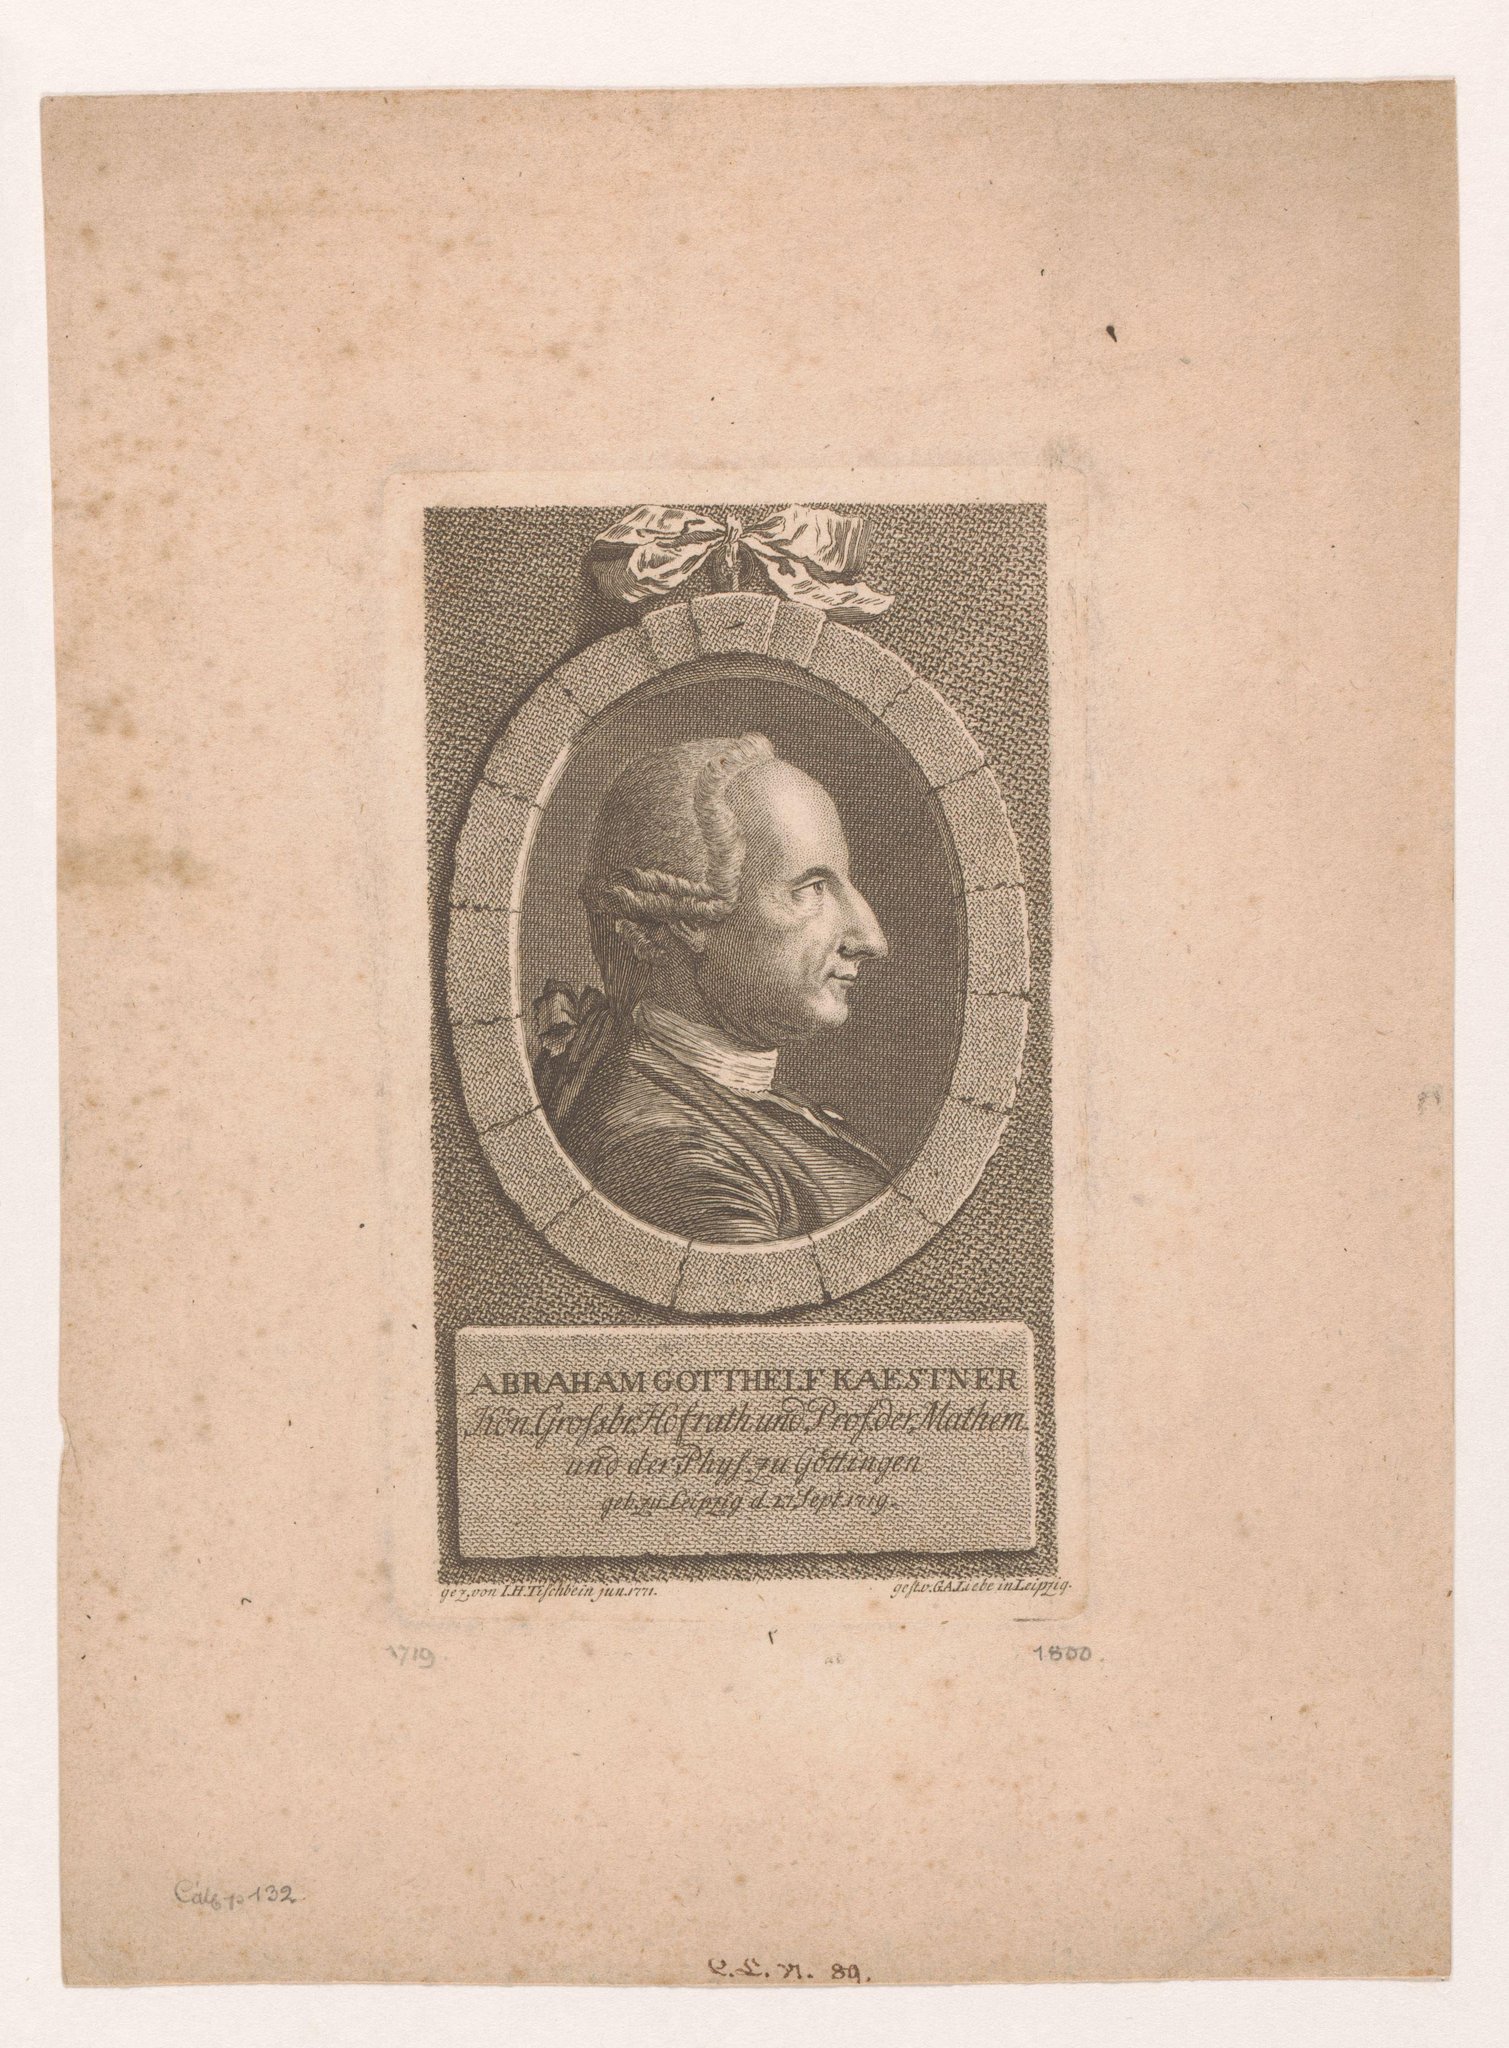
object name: print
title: Portret van Abraham Gotthelf Kaestner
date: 1771-1819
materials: paper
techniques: engraving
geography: leipzig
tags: astronomy (and cosmography) (+ portrait of scholar, scientist), historical persons, mathematics (+ portrait of scholar, scientist)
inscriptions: collector's mark: Lugt 2228